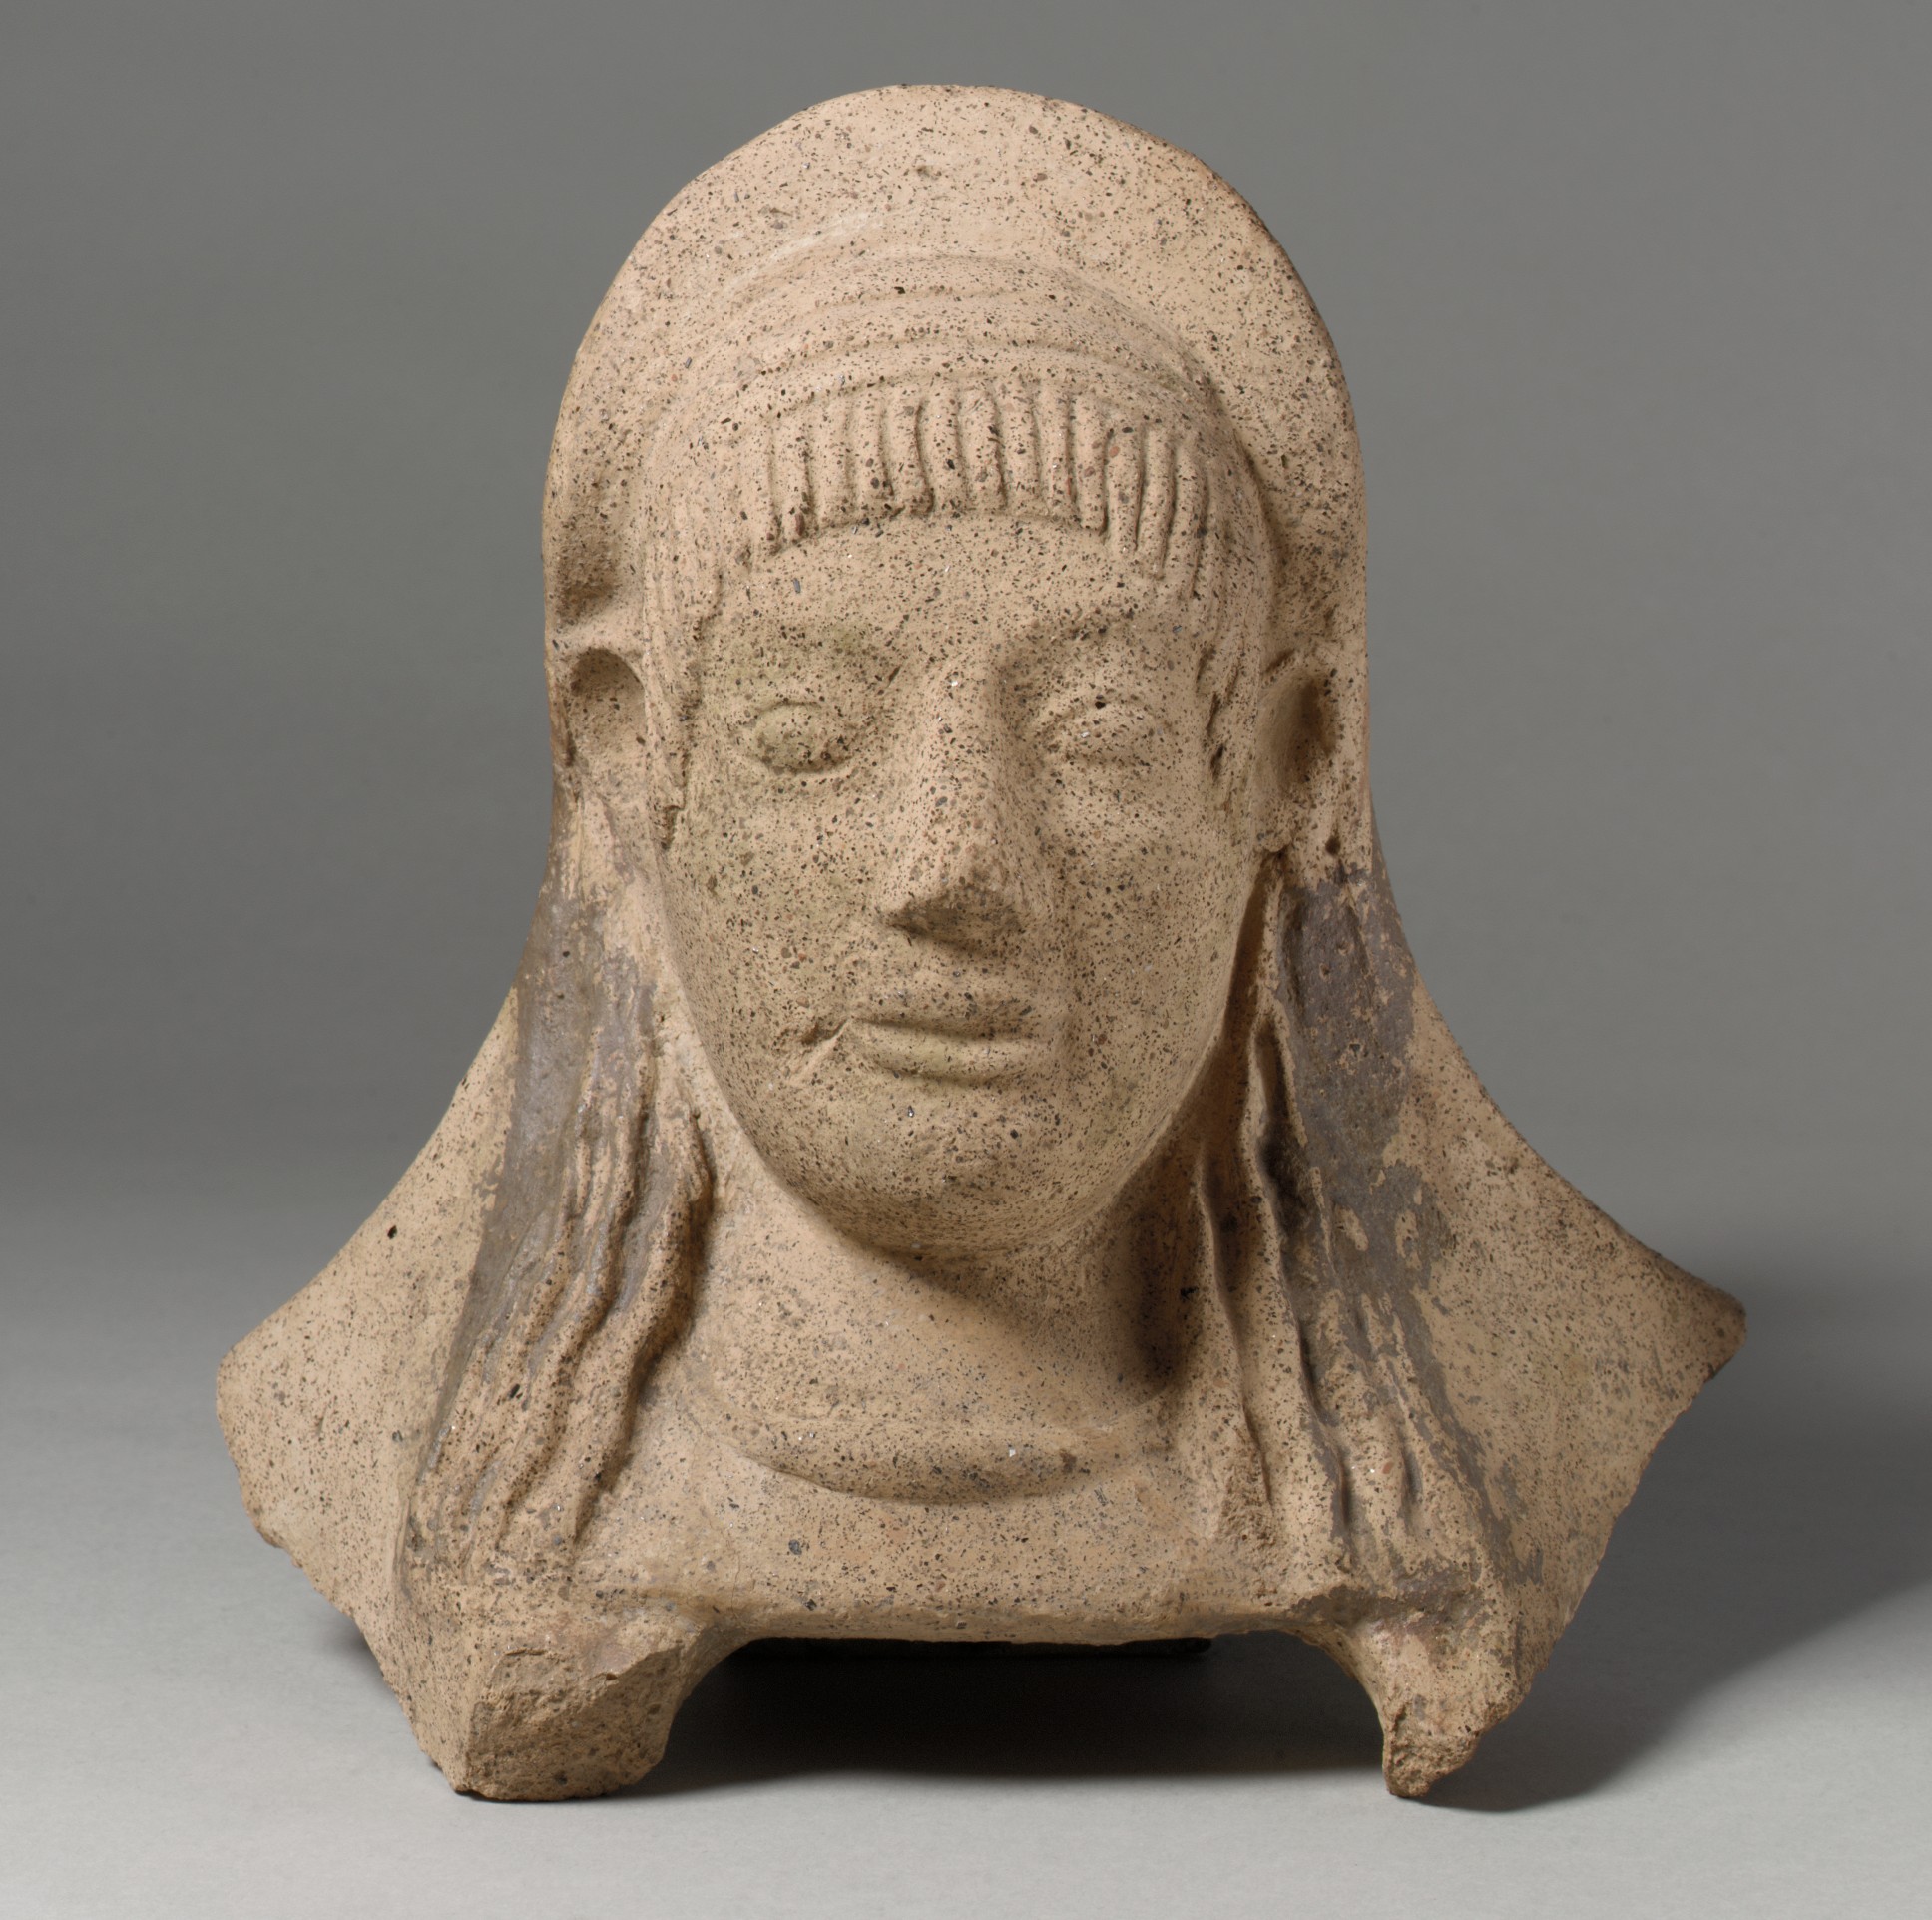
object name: protome of a woman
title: Terracotta protome of a woman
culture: etruscan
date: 500 BCE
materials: terracotta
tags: heads,women